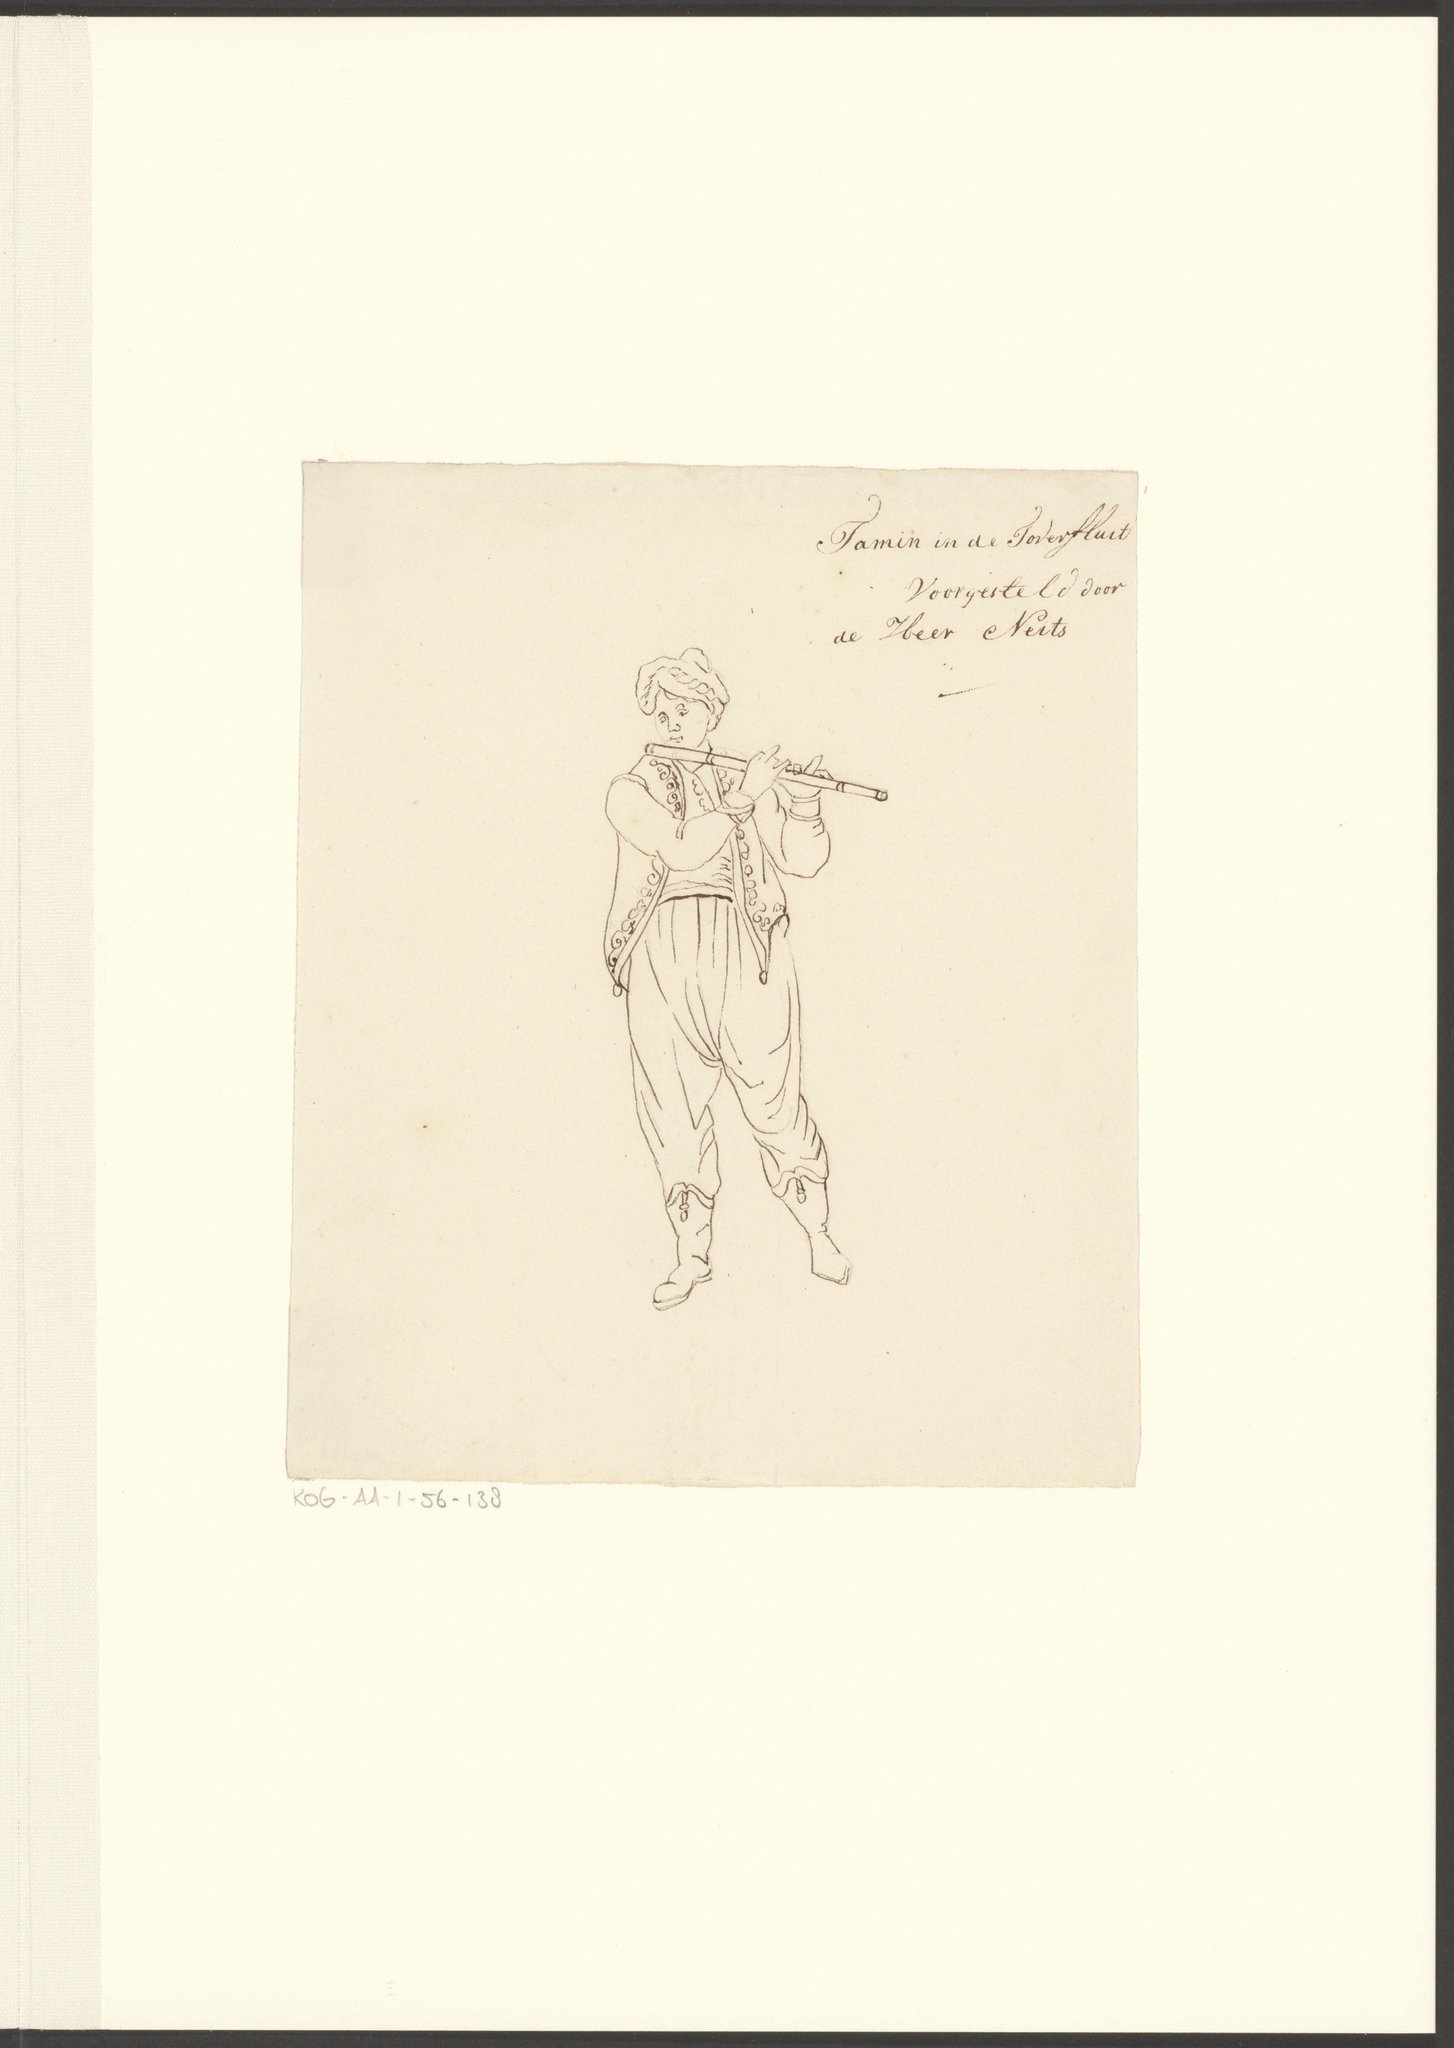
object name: drawing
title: Portret van toneelspeler Jan Neyts als Tamin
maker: johannes jelgerhuis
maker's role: draughtsman, painter, print maker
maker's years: 1770-1836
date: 1788-1836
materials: ink, paper, pencil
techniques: pen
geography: amsterdam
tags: historical persons, portrait of actor, actress, actor (on the stage), amsterdam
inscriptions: inscription: ‘Tamin, in de Toverfluit, / Voorgesteld door / de Heer Neits’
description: Voorbereidende tekening op de prentserie Acteurs en actrices in verschillende rollen van Johannes Jelgerhuis.